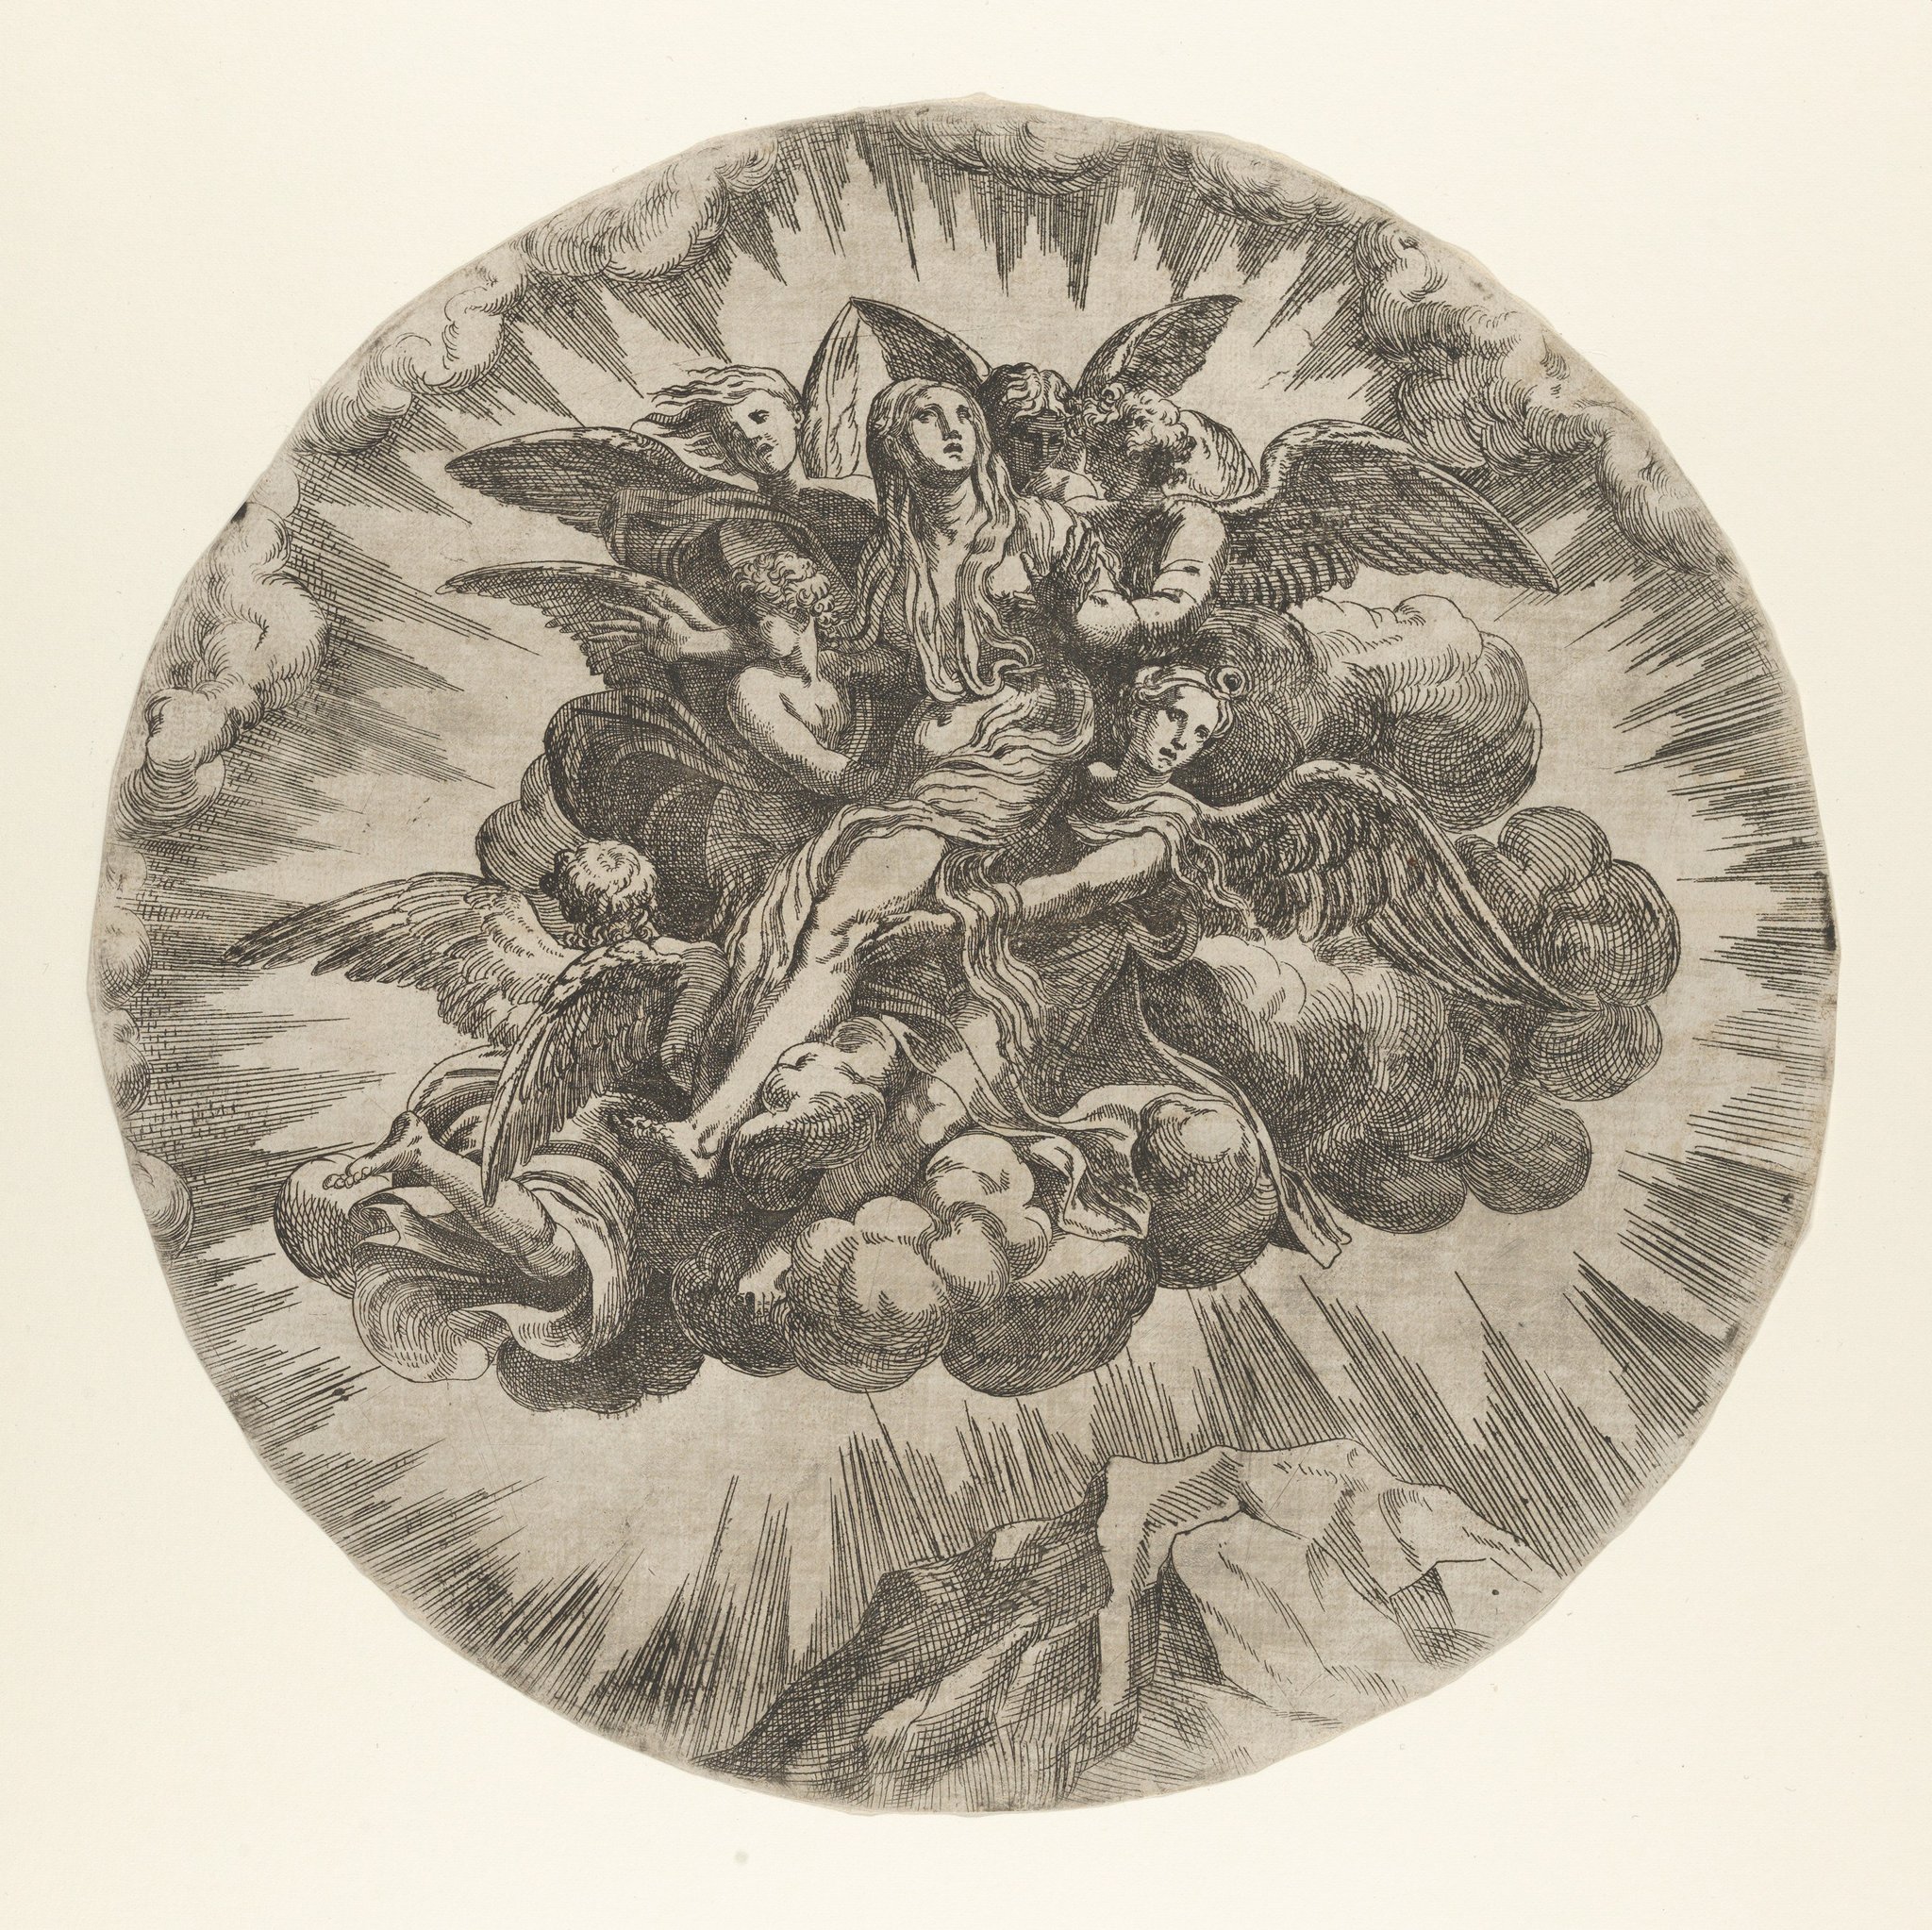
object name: print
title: Mary Magdalen carried to Heaven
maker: anonymous, french, school of fontainebleau, 16th century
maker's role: artist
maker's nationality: french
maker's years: 1500-1600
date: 1544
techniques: etching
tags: mary magdalene,heaven